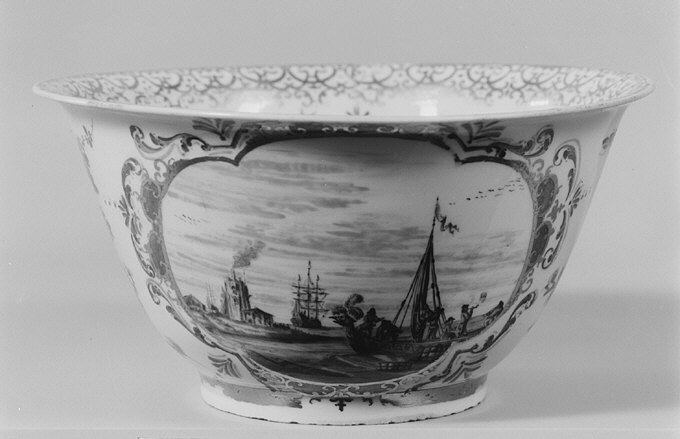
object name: bowl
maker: meissen manufactory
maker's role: manufactory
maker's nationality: german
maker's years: 1710-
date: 1730-1735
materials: hard paste porcelain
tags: ships